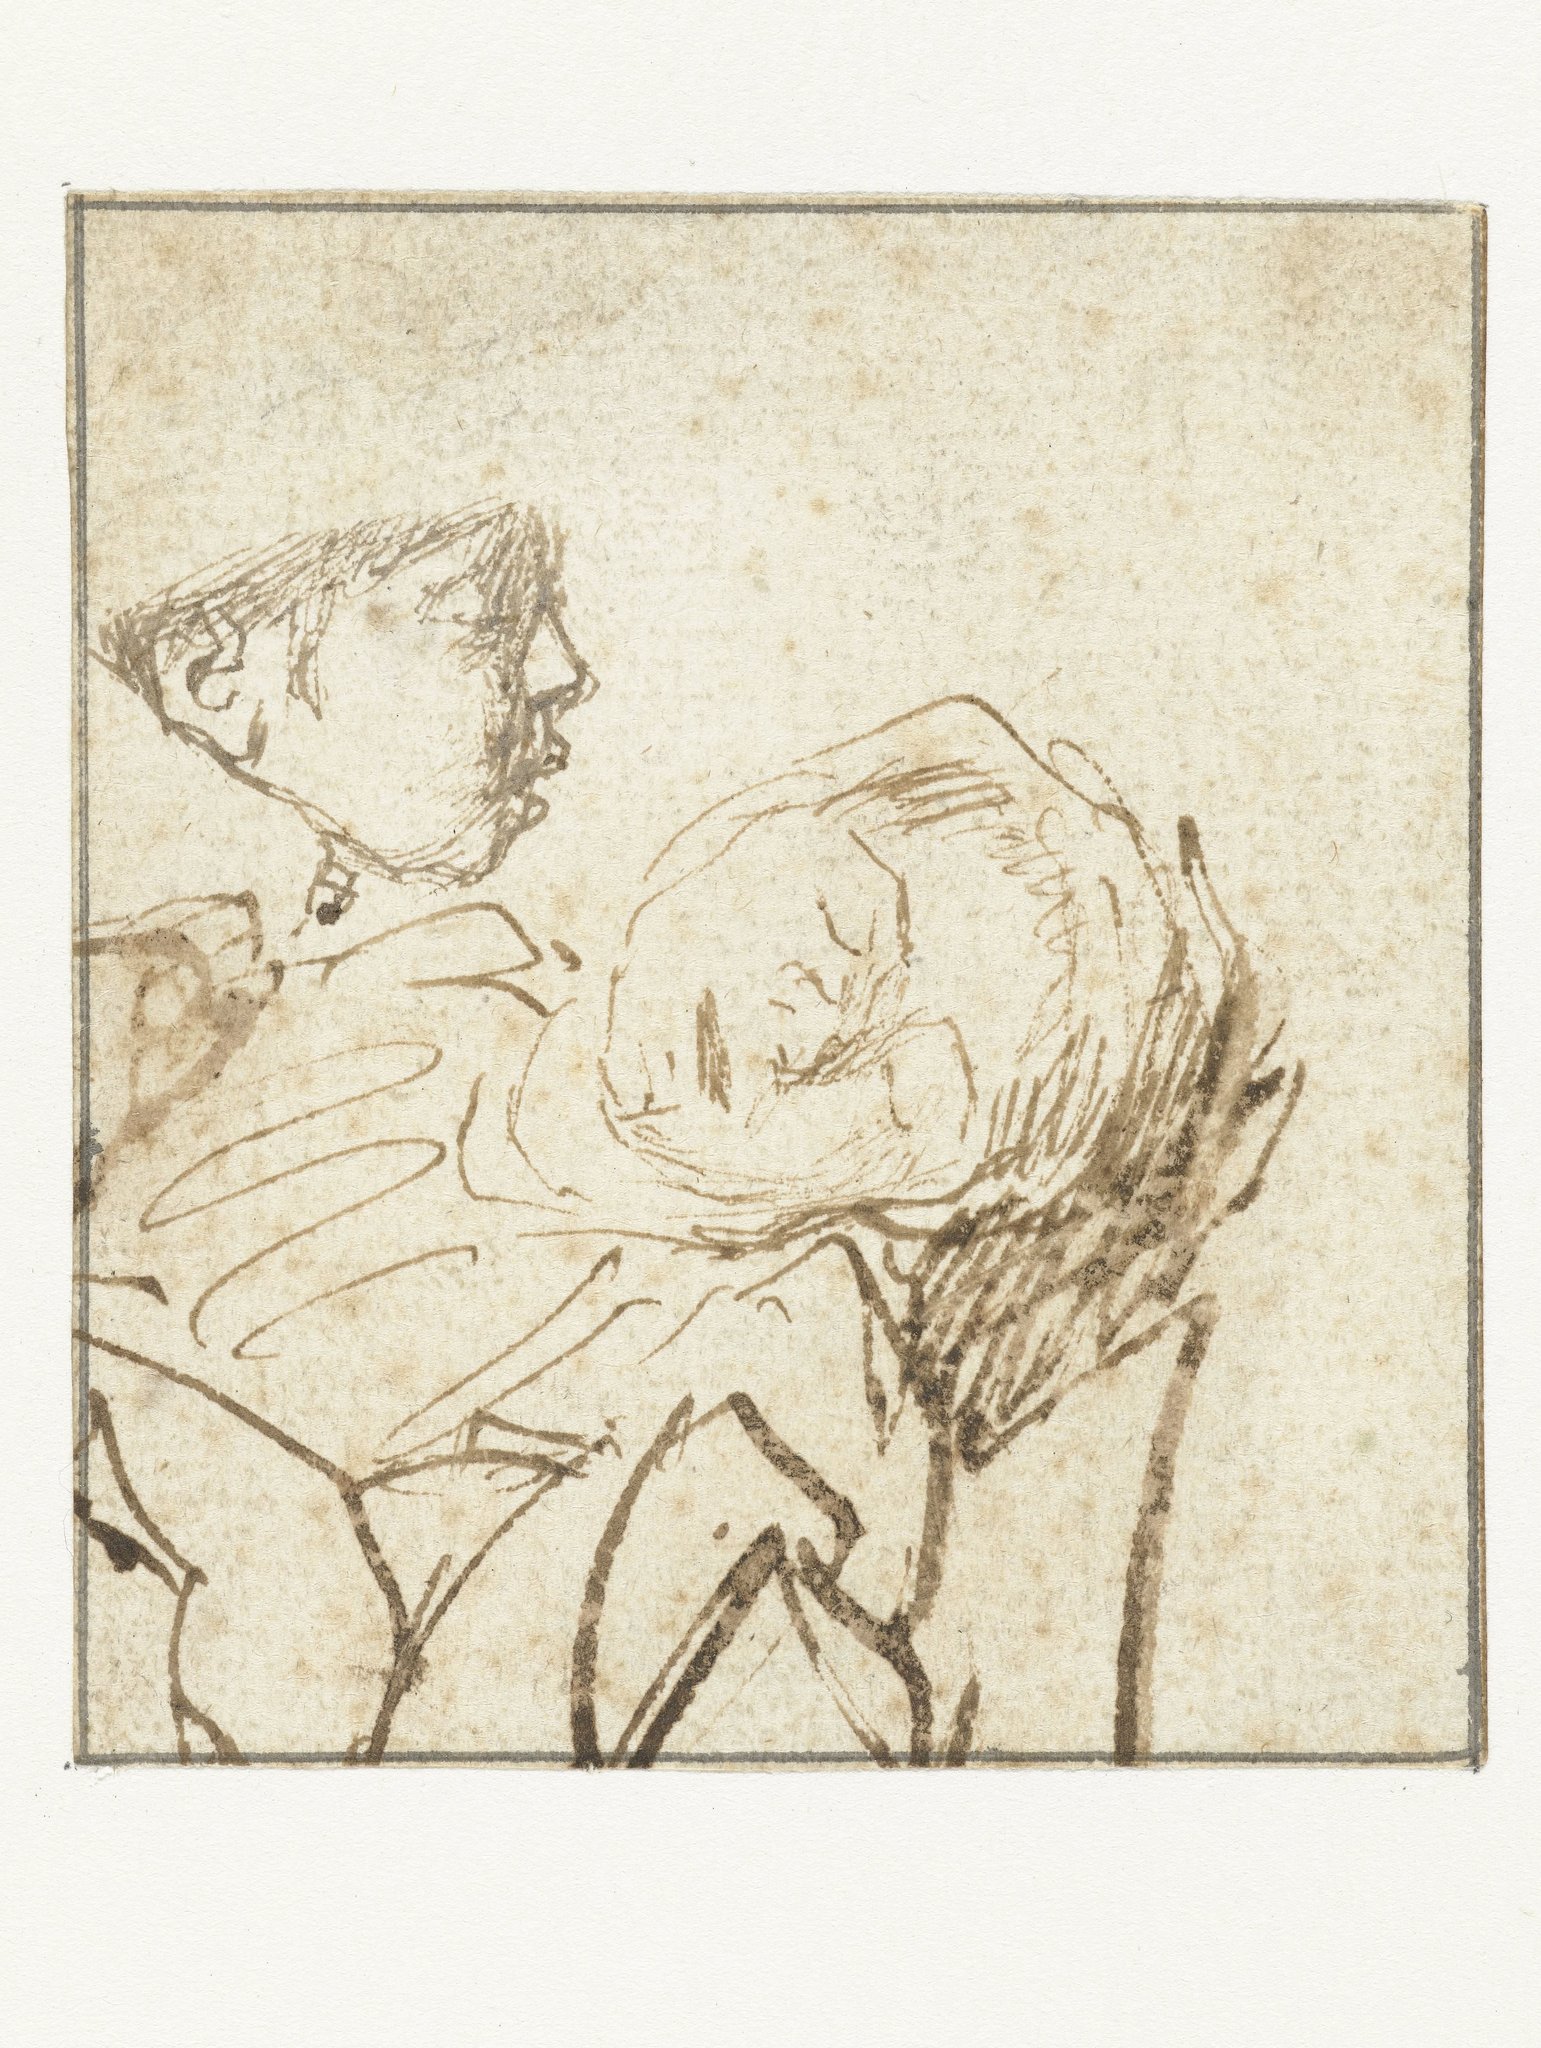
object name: drawing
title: Head of a Sleeping Girl and a Boy’s Head in Profile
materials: ink, paper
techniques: pen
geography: amsterdam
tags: boy (child between toddler and youth), watching a sleeping child, sleeping; unconsciousness